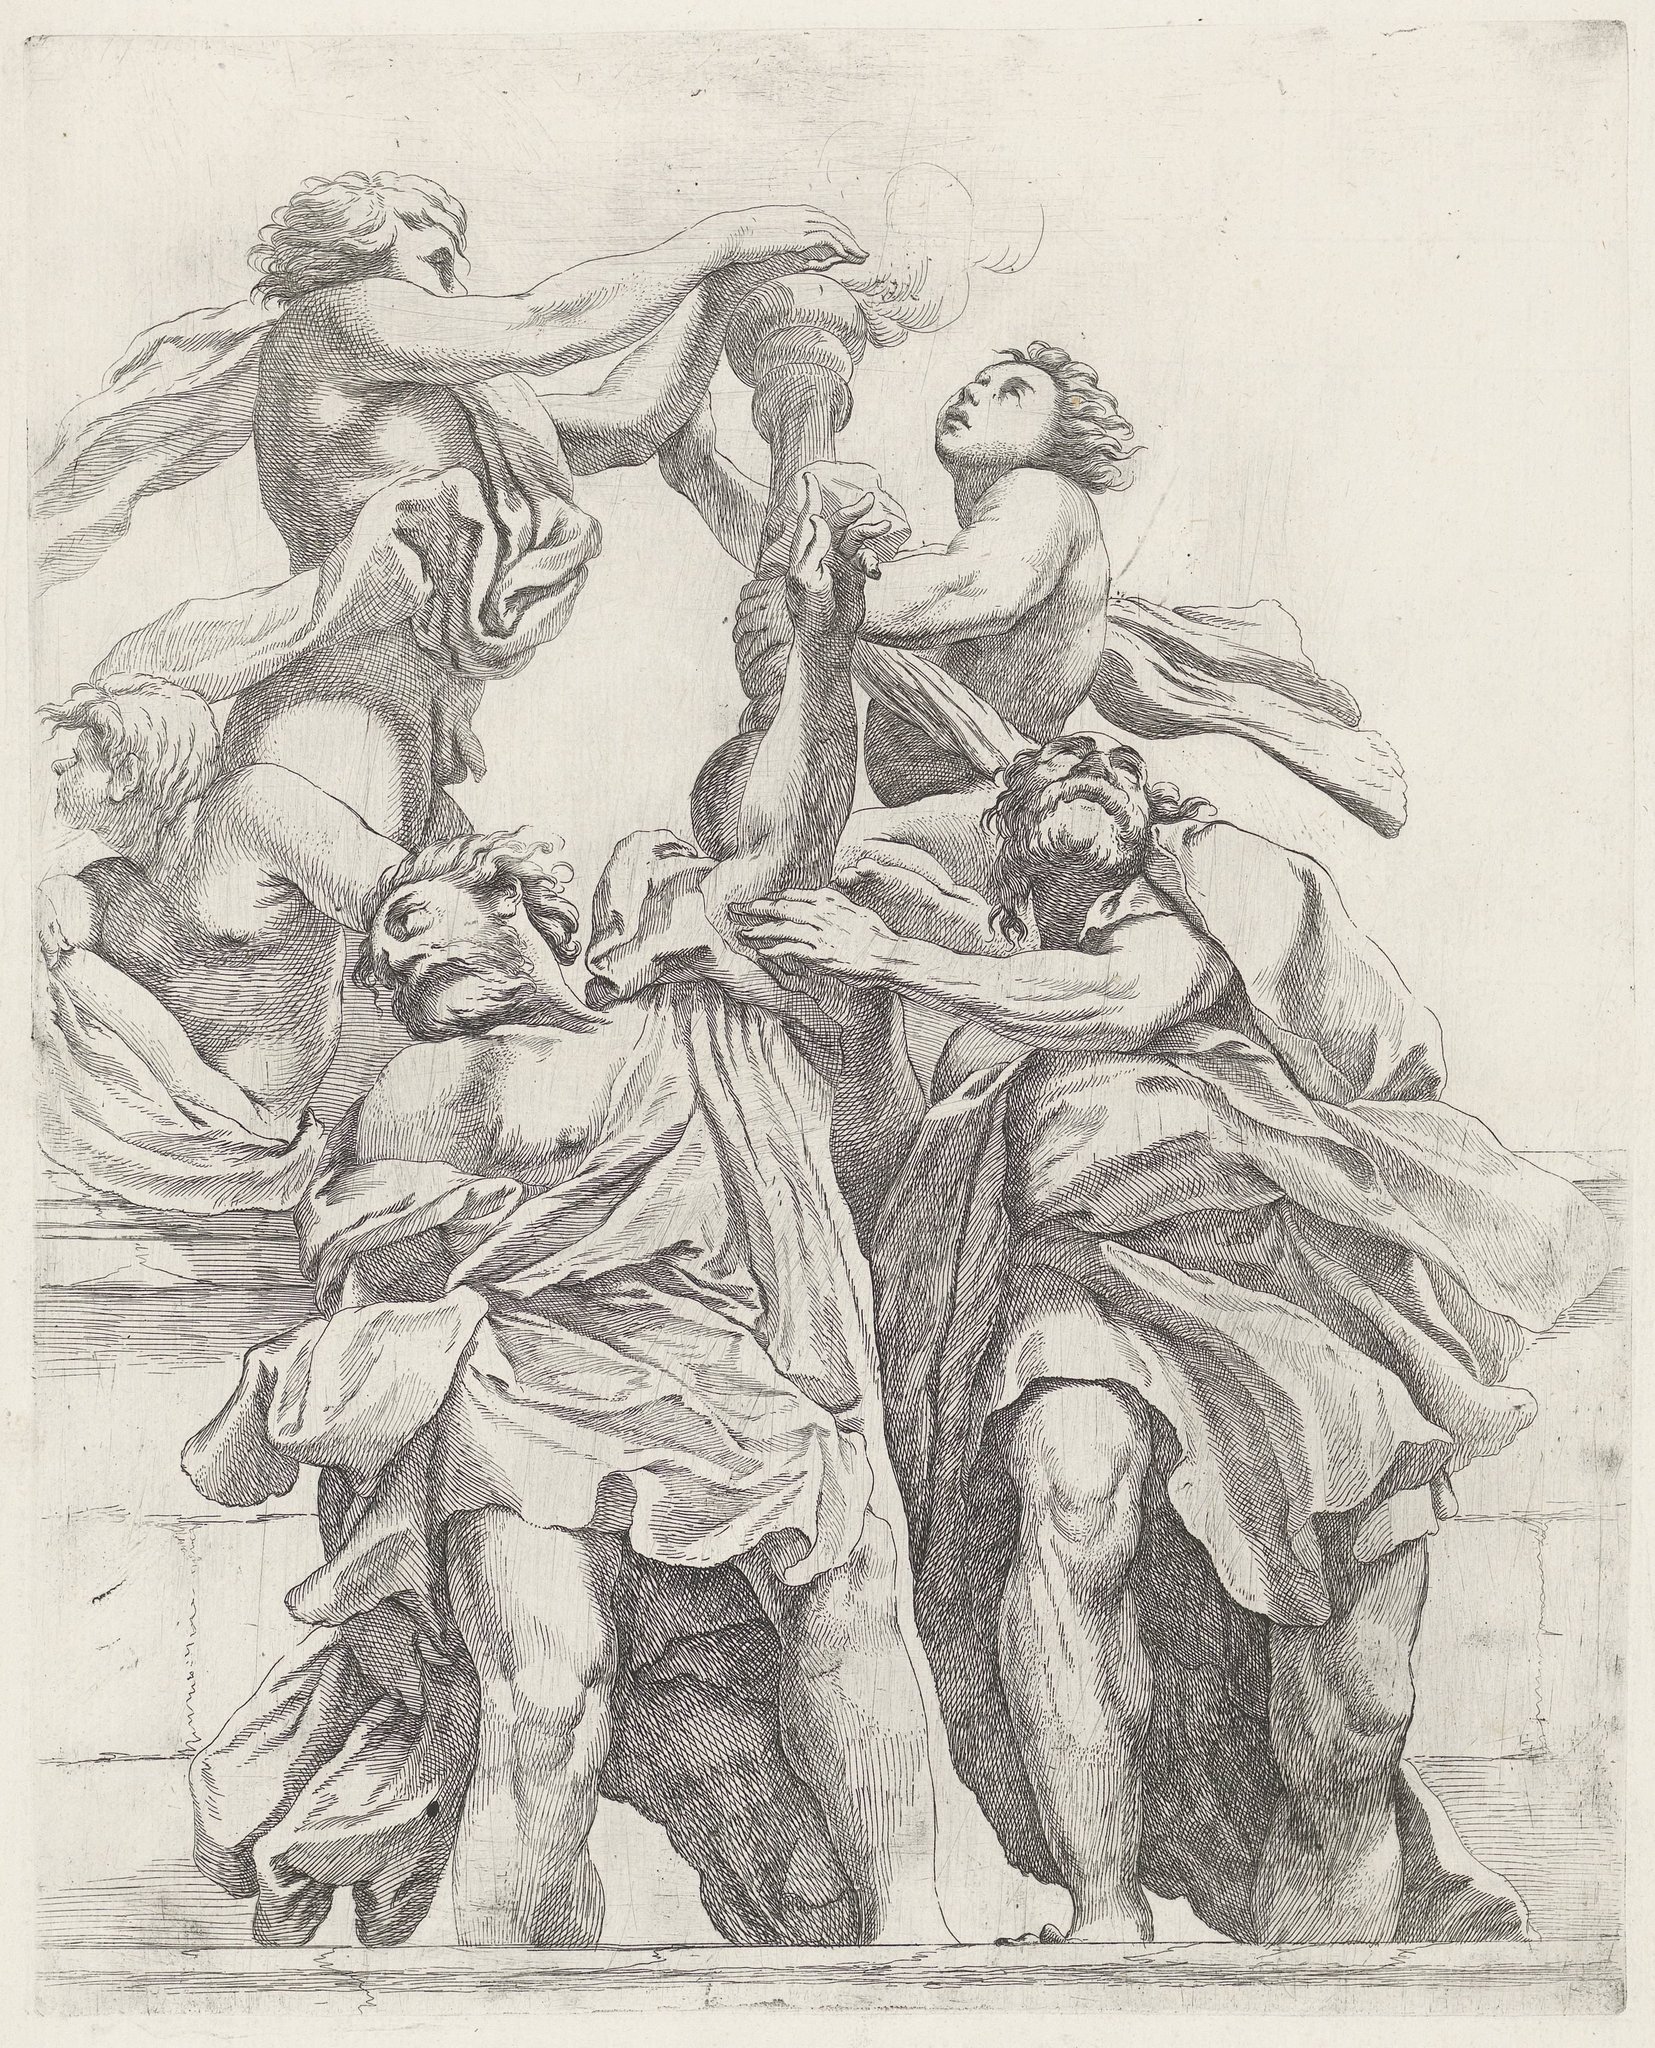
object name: print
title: Koepeldecoraties door Correggio in de S. Giovanni Evangelista in Parma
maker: giovanni battista vanni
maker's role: print maker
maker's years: 1599-1660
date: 1609-1660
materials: paper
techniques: etching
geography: parma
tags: (single) apostle, unspecified, angels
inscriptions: collector's mark: Lugt 240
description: Prent uit een reeks van 8 prenten naar de koepeldecoraties door Correggio in de S. Giovanni Evangelista in Parma.